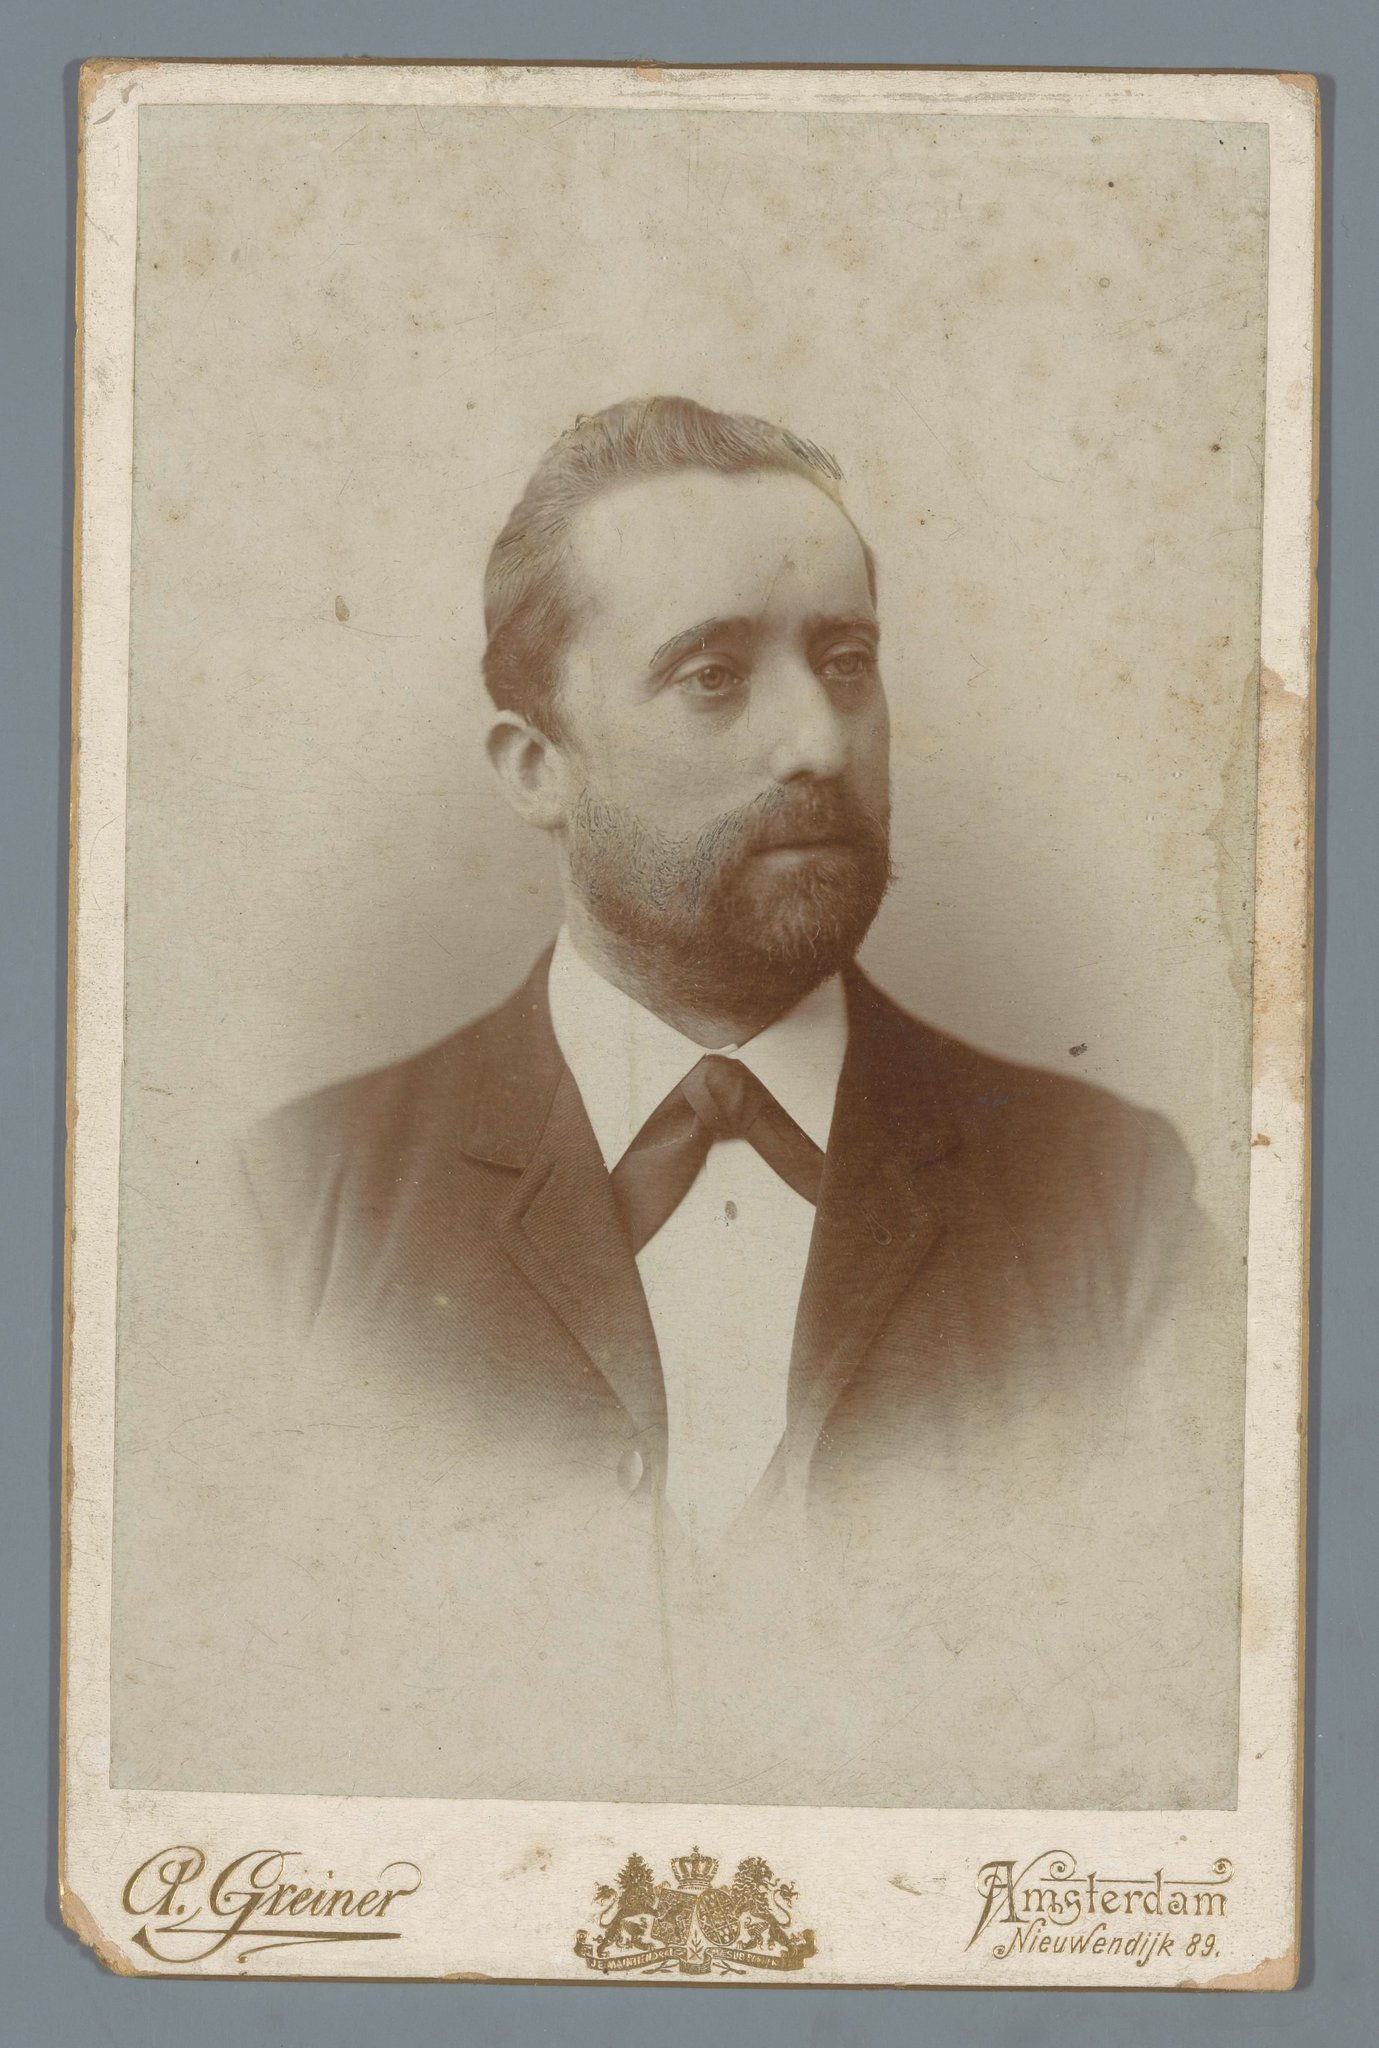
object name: cabinet photograph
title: Portret van een onbekende man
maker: albert greiner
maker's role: fotograaf, fotostudio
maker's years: 1833-1890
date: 1861-1890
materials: cardboard, photographic support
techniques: collodion silver print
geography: amsterdam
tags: adult man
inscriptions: name: ‘Albert Greiner Photograaf van wijlen Z.M. den Koning Willem III en H.M. de Koningin Weduwe Amsterdam Nieuwendijk 89. (...)’